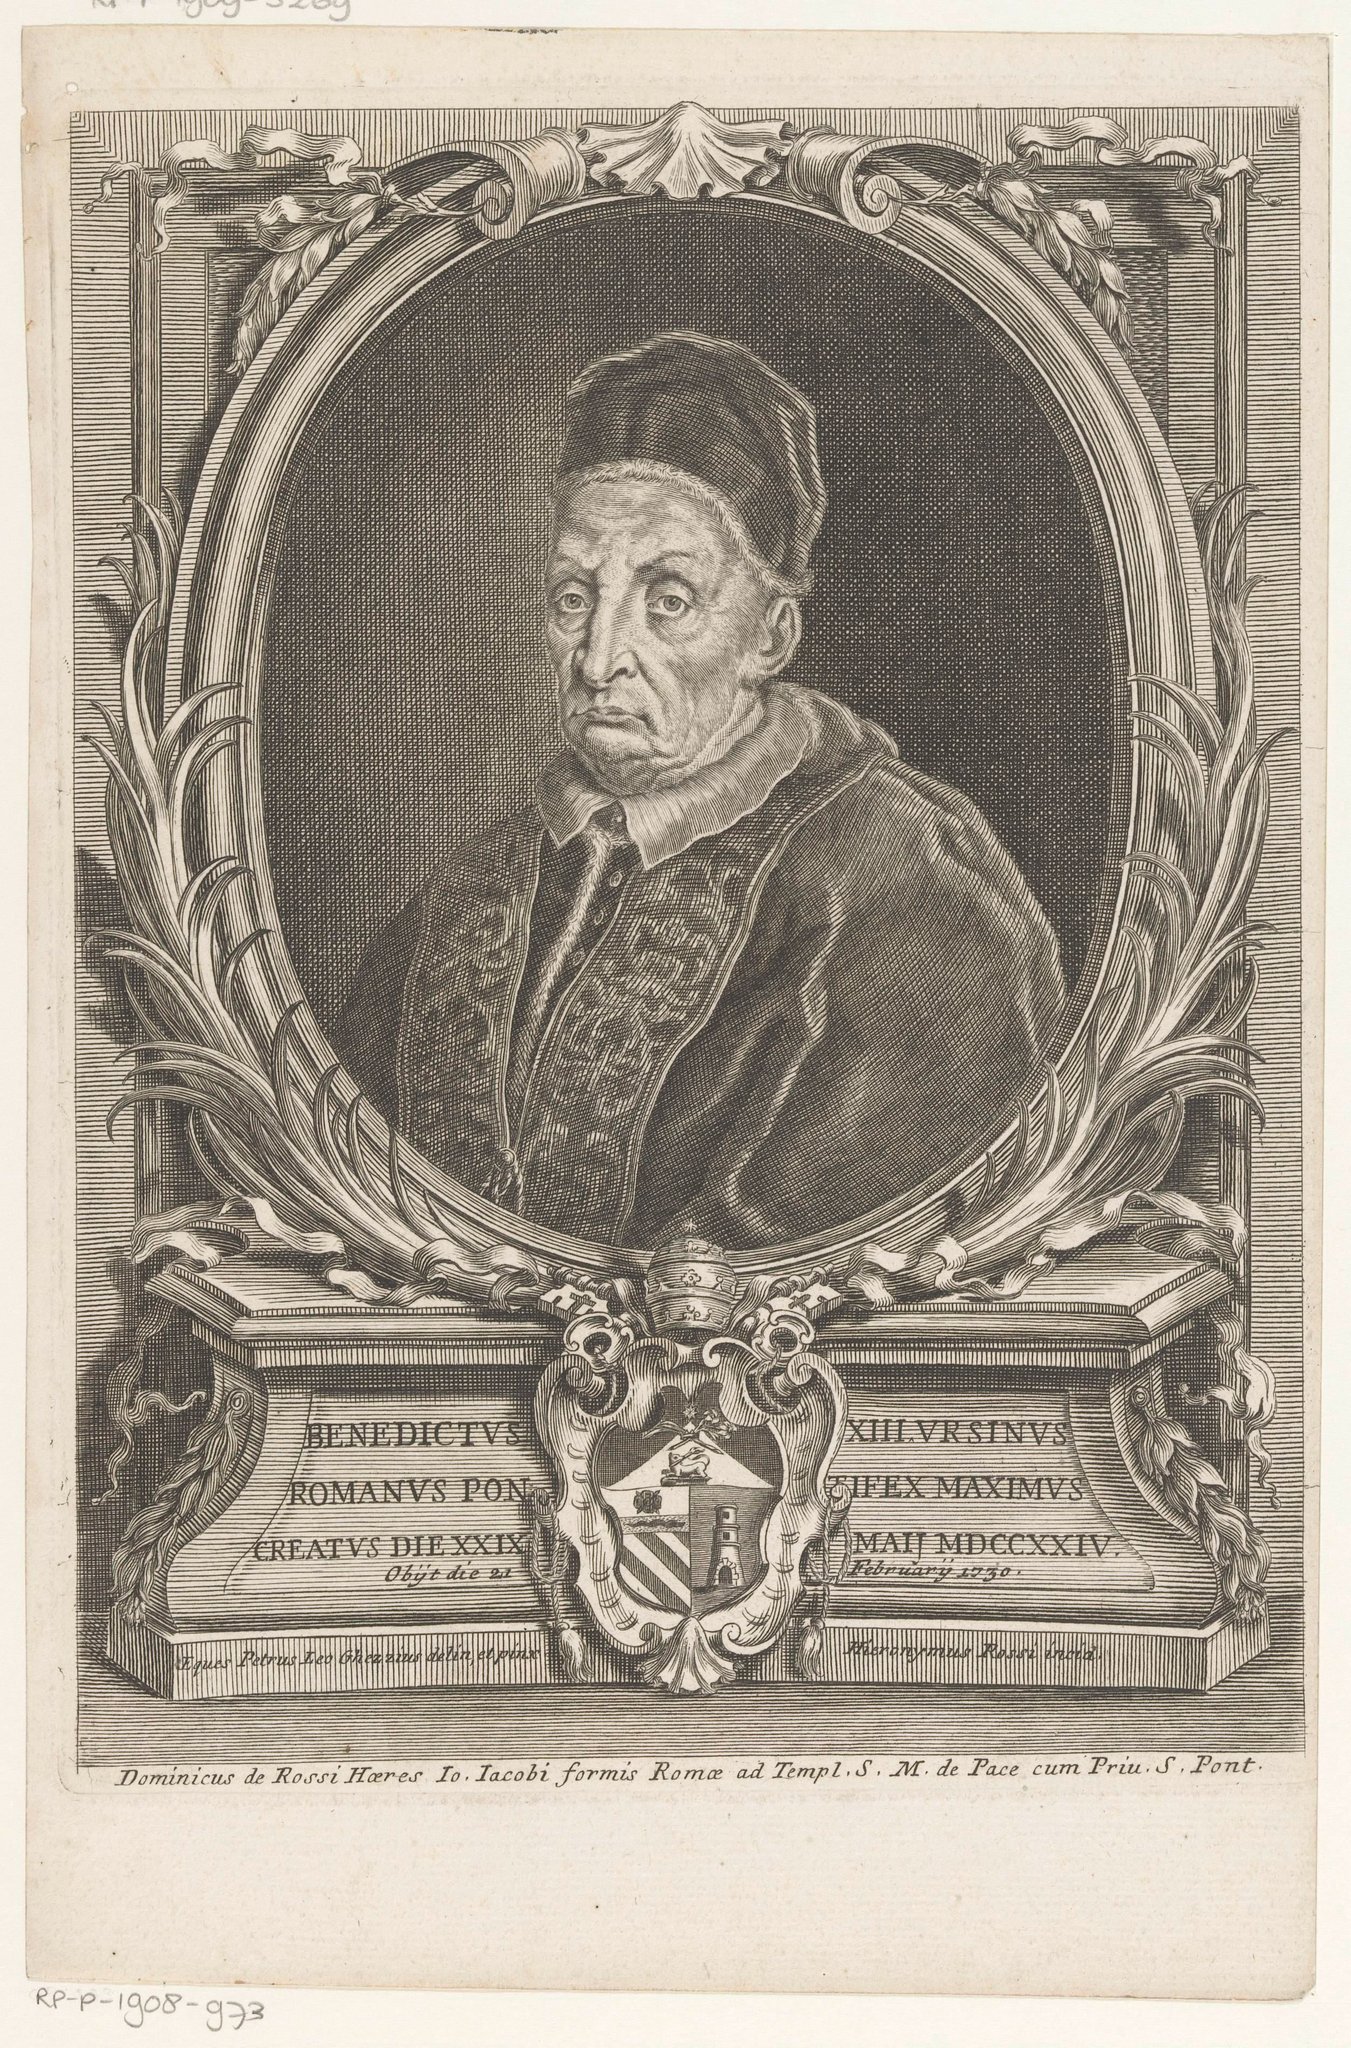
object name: print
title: Portret van paus Benedictus XIII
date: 1730-1762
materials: paper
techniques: engraving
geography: italy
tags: benedictus xiii, historical persons, pope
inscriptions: collector's mark: Lugt 2228